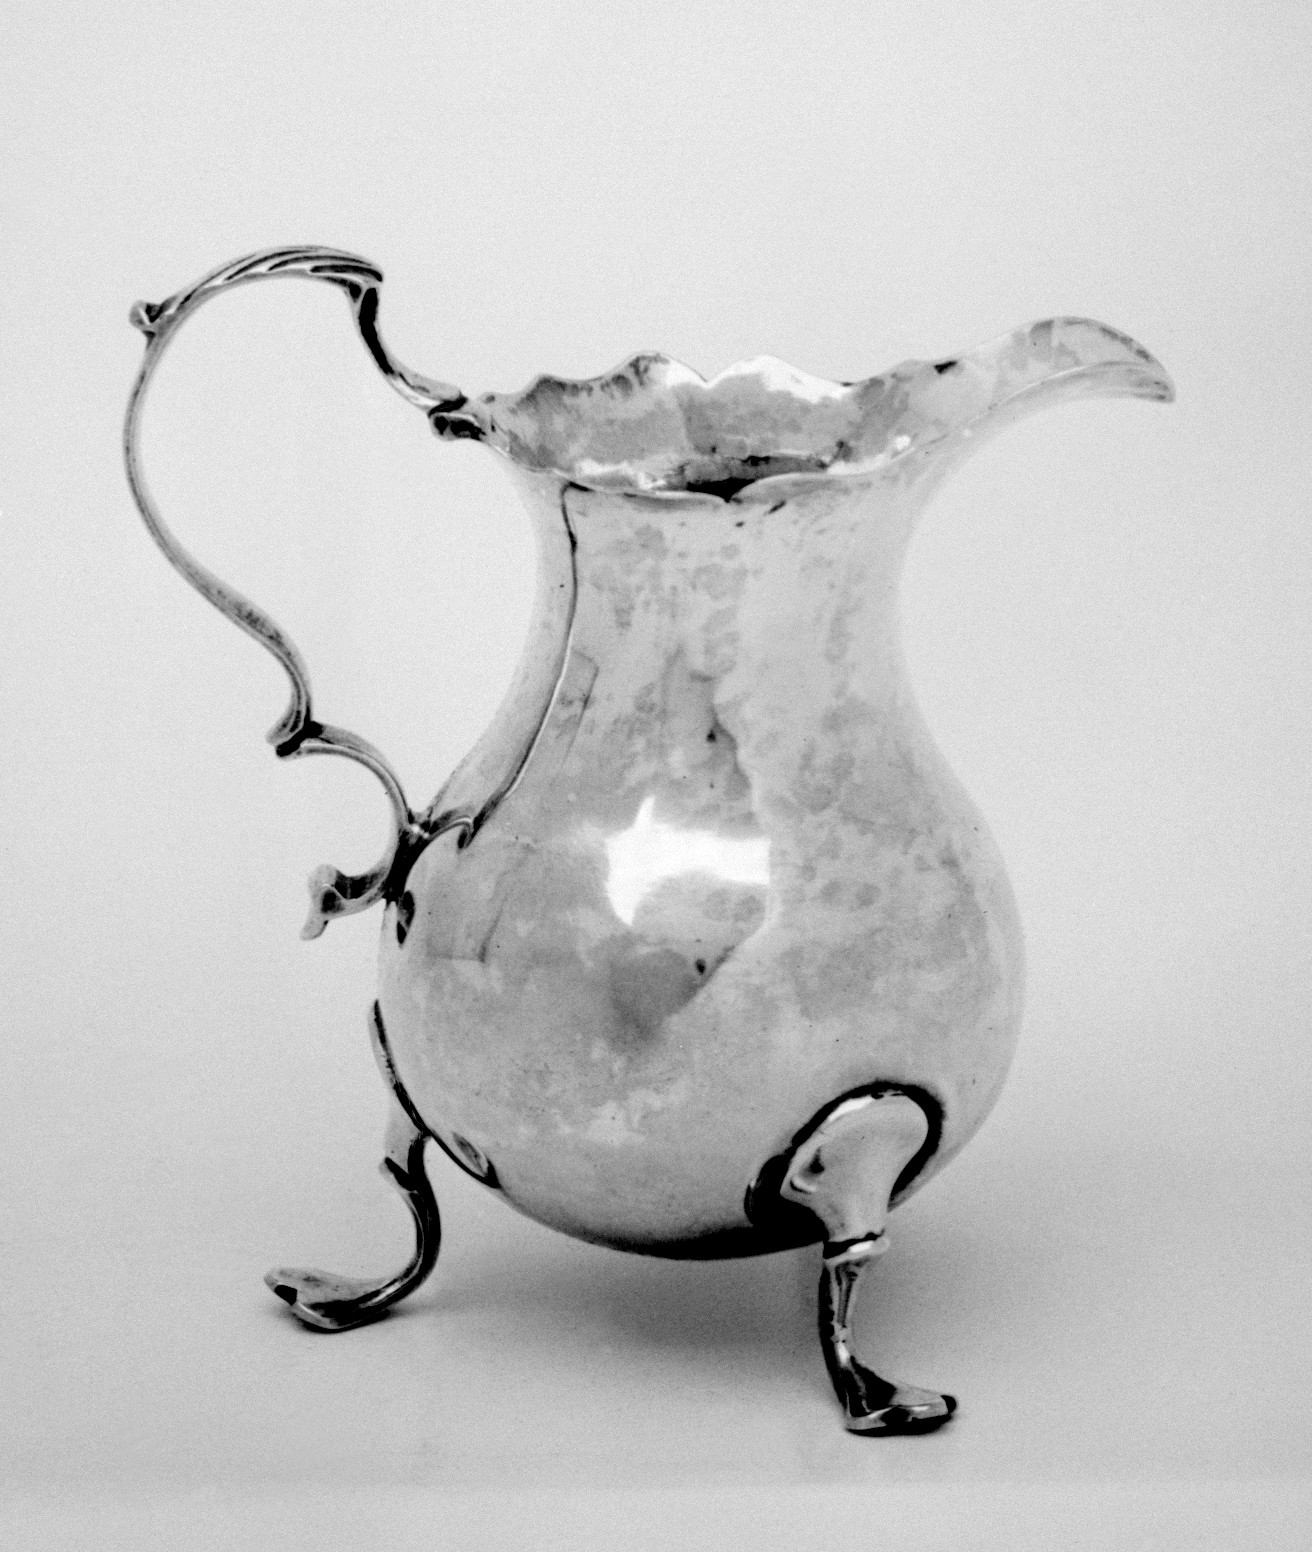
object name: cream jug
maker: william caldecott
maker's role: maker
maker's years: 1756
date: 1767-1768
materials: silver